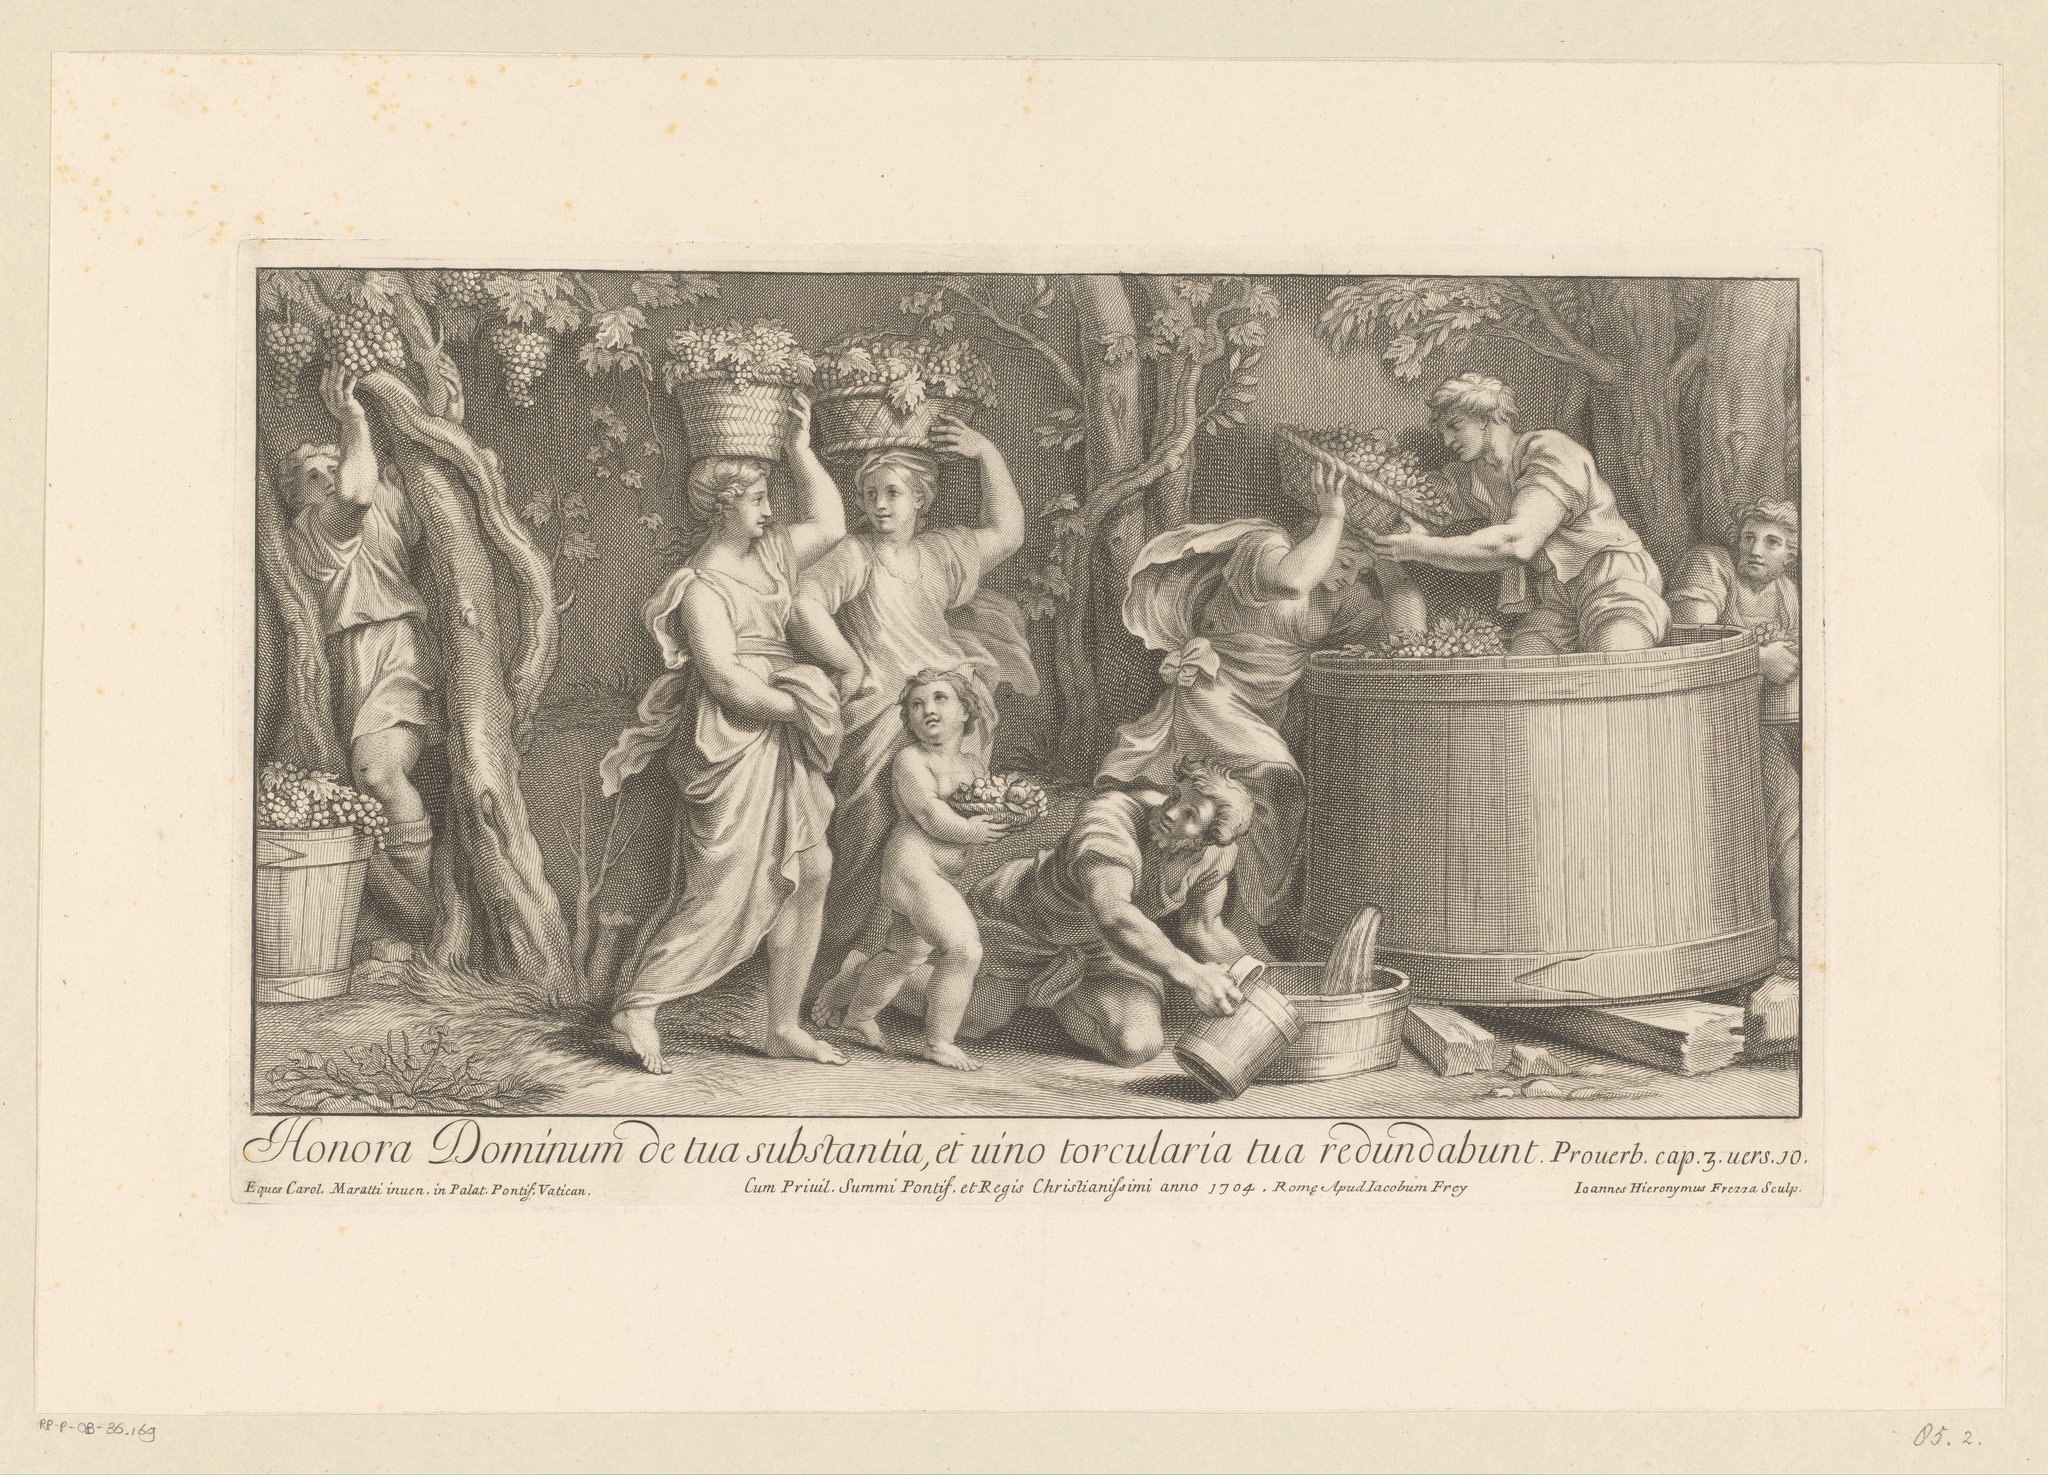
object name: print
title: Honora Dominium de tua substantia, et vino torcularia tua redundabunt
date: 1704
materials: paper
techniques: engraving, etching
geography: rome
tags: harvest, vintage, grape harvest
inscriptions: collector's mark: Lugt 240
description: Vrouwen en een naakte jongen dragen druiven naar een grote ton, waar de druiven worden geperst. Op de achtergrond links een man die druiven plukt.